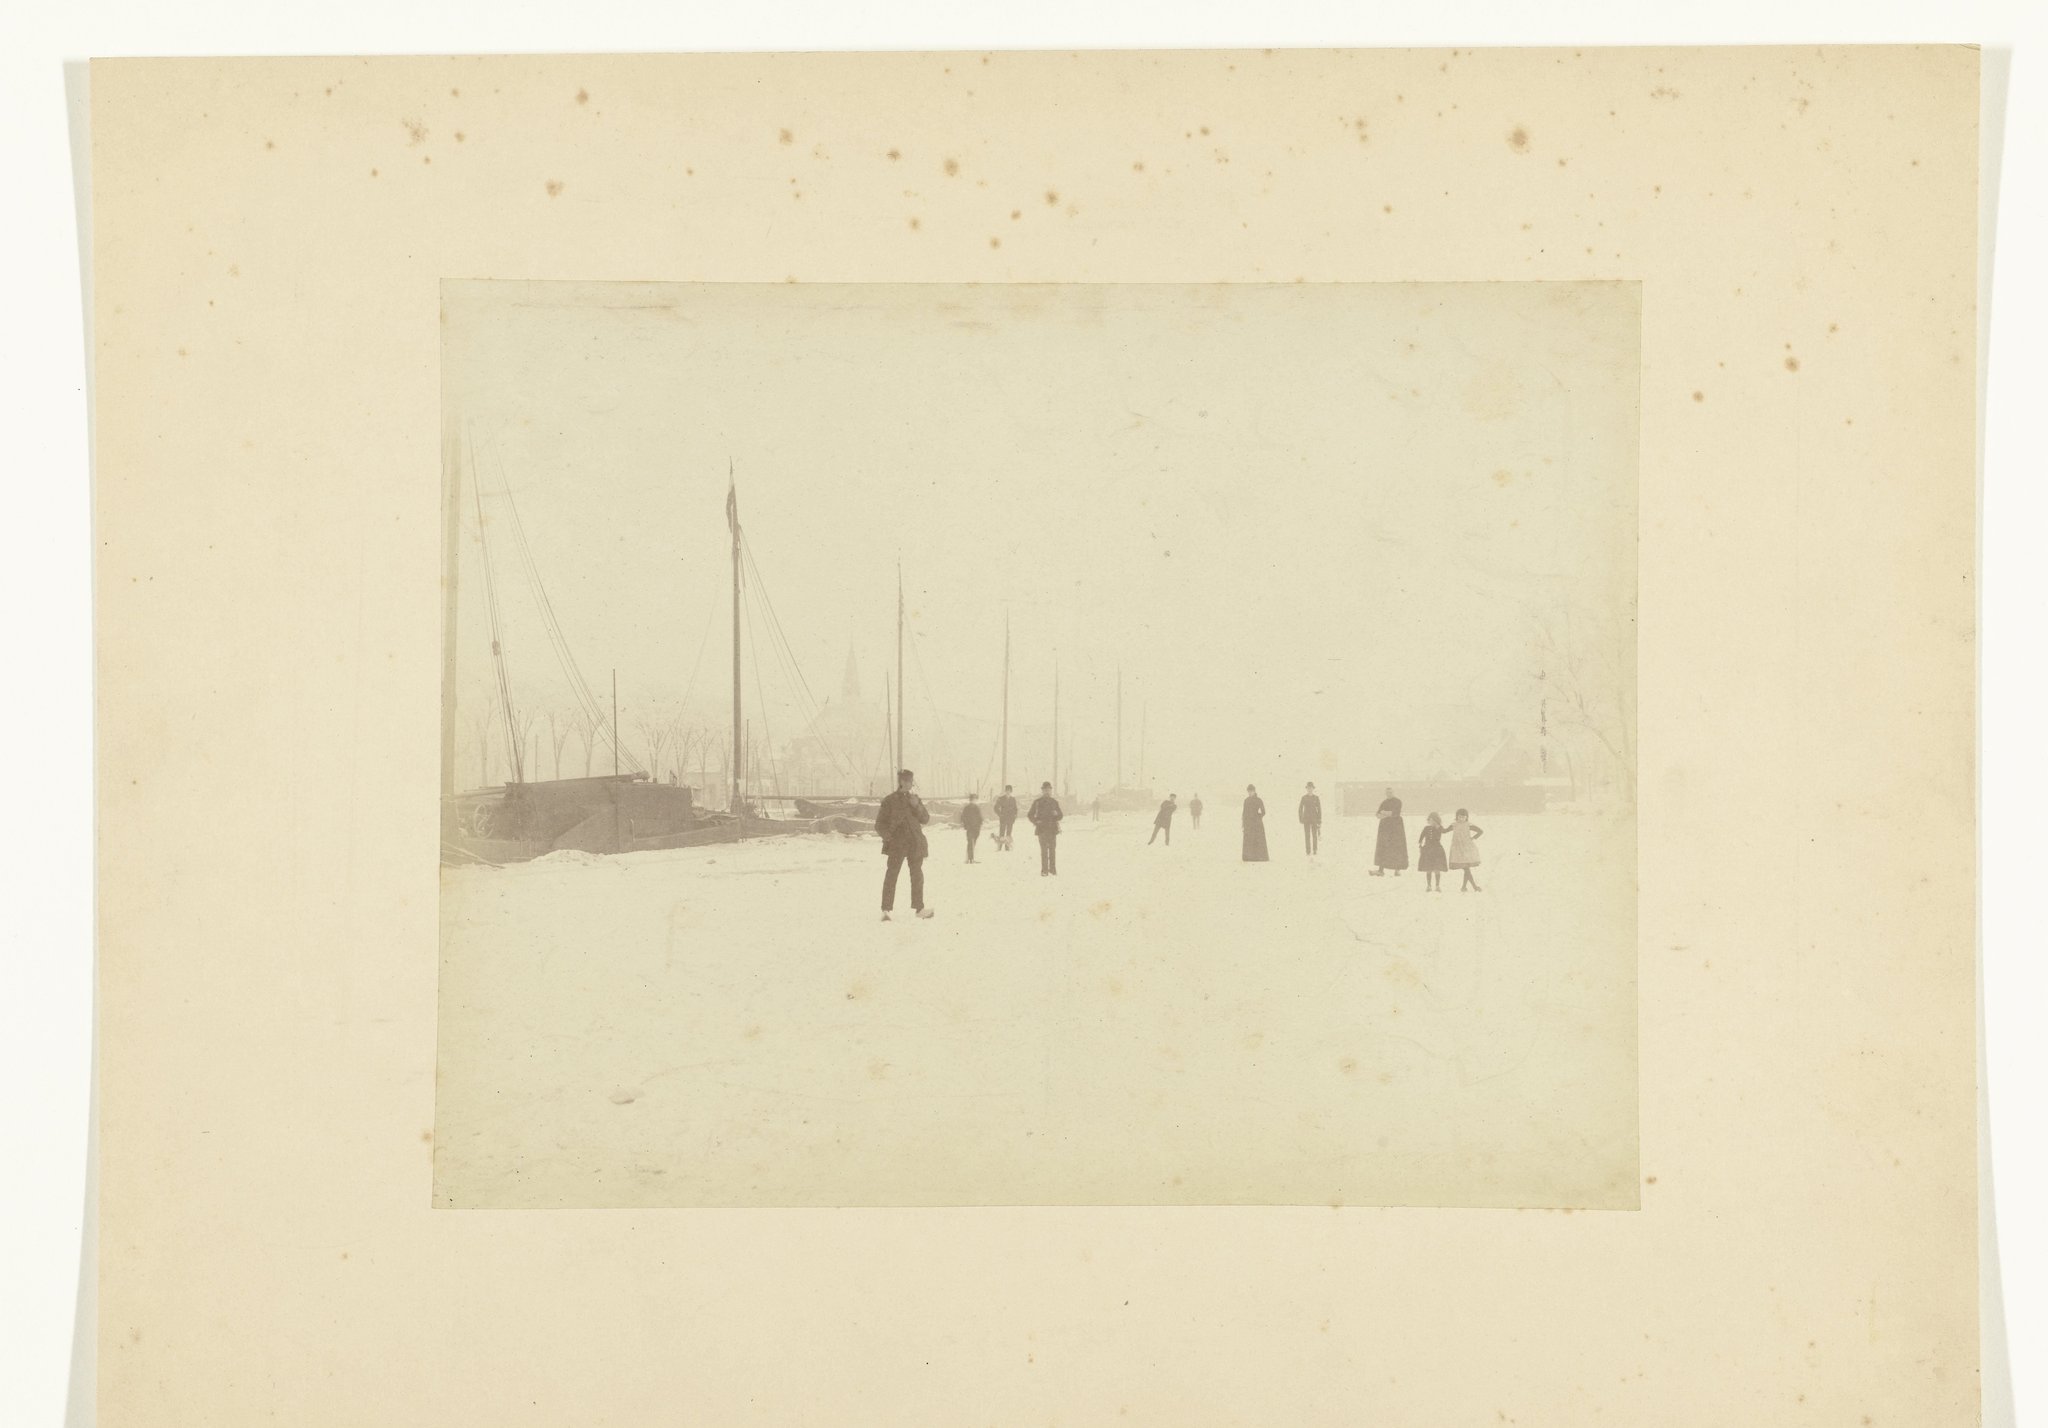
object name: photograph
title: Gezicht op een verijst water, waarop mensen met klompen en schaatsen. Boten en een kerk op de achtergrond.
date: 1880-1905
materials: cardboard, photographic support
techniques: albumen print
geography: leiden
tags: ice ~ freezing weather, skates (winter sports)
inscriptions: annotation: ‘goedeljee’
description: Gezicht op een verijst water, waarop mensen met klompen en schaatsen. Boten en een kerk op de achtergrond.